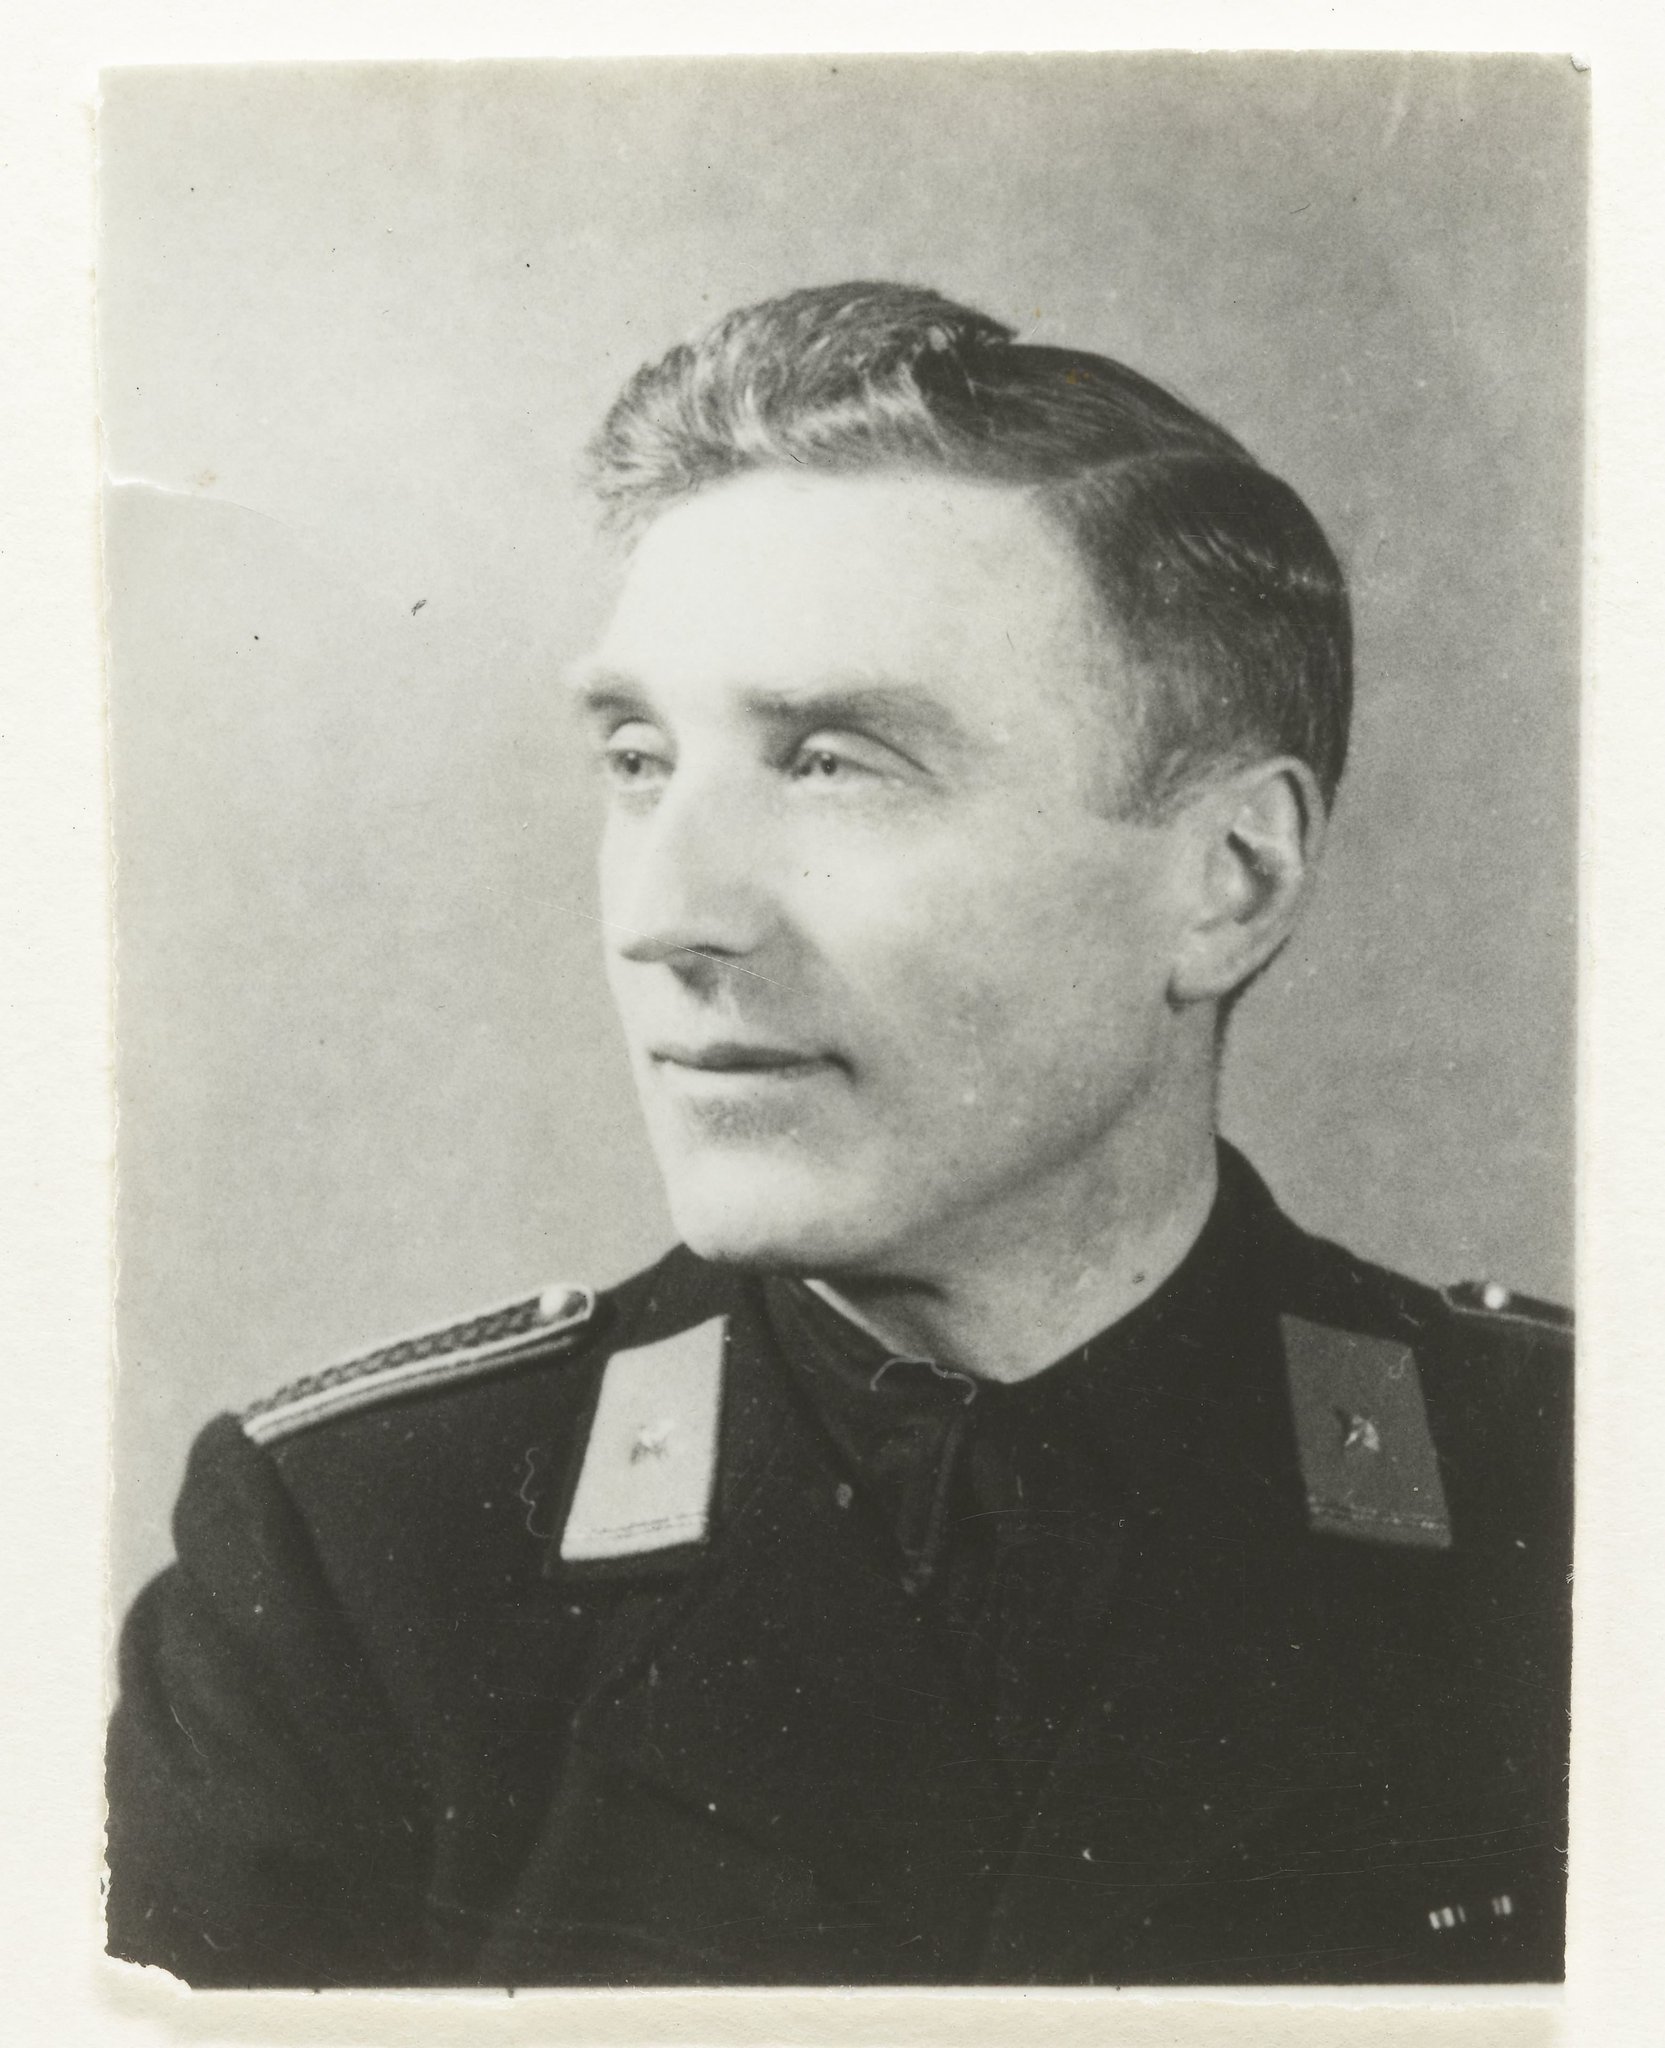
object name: contact print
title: NSB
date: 1940-1944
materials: photographic support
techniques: gelatin silver print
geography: netherlands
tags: anonymous historical person portrayed, netherlands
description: Portret van een lid van de WA. Op zijn kraag een distinctief met een ster en een streep eronder. Op zijn schouder gevlochten schouderbedekking. Hij is een vaandrig in de WA en behoort tot het lager kader. Oudere man met kuif, blootshoofd.